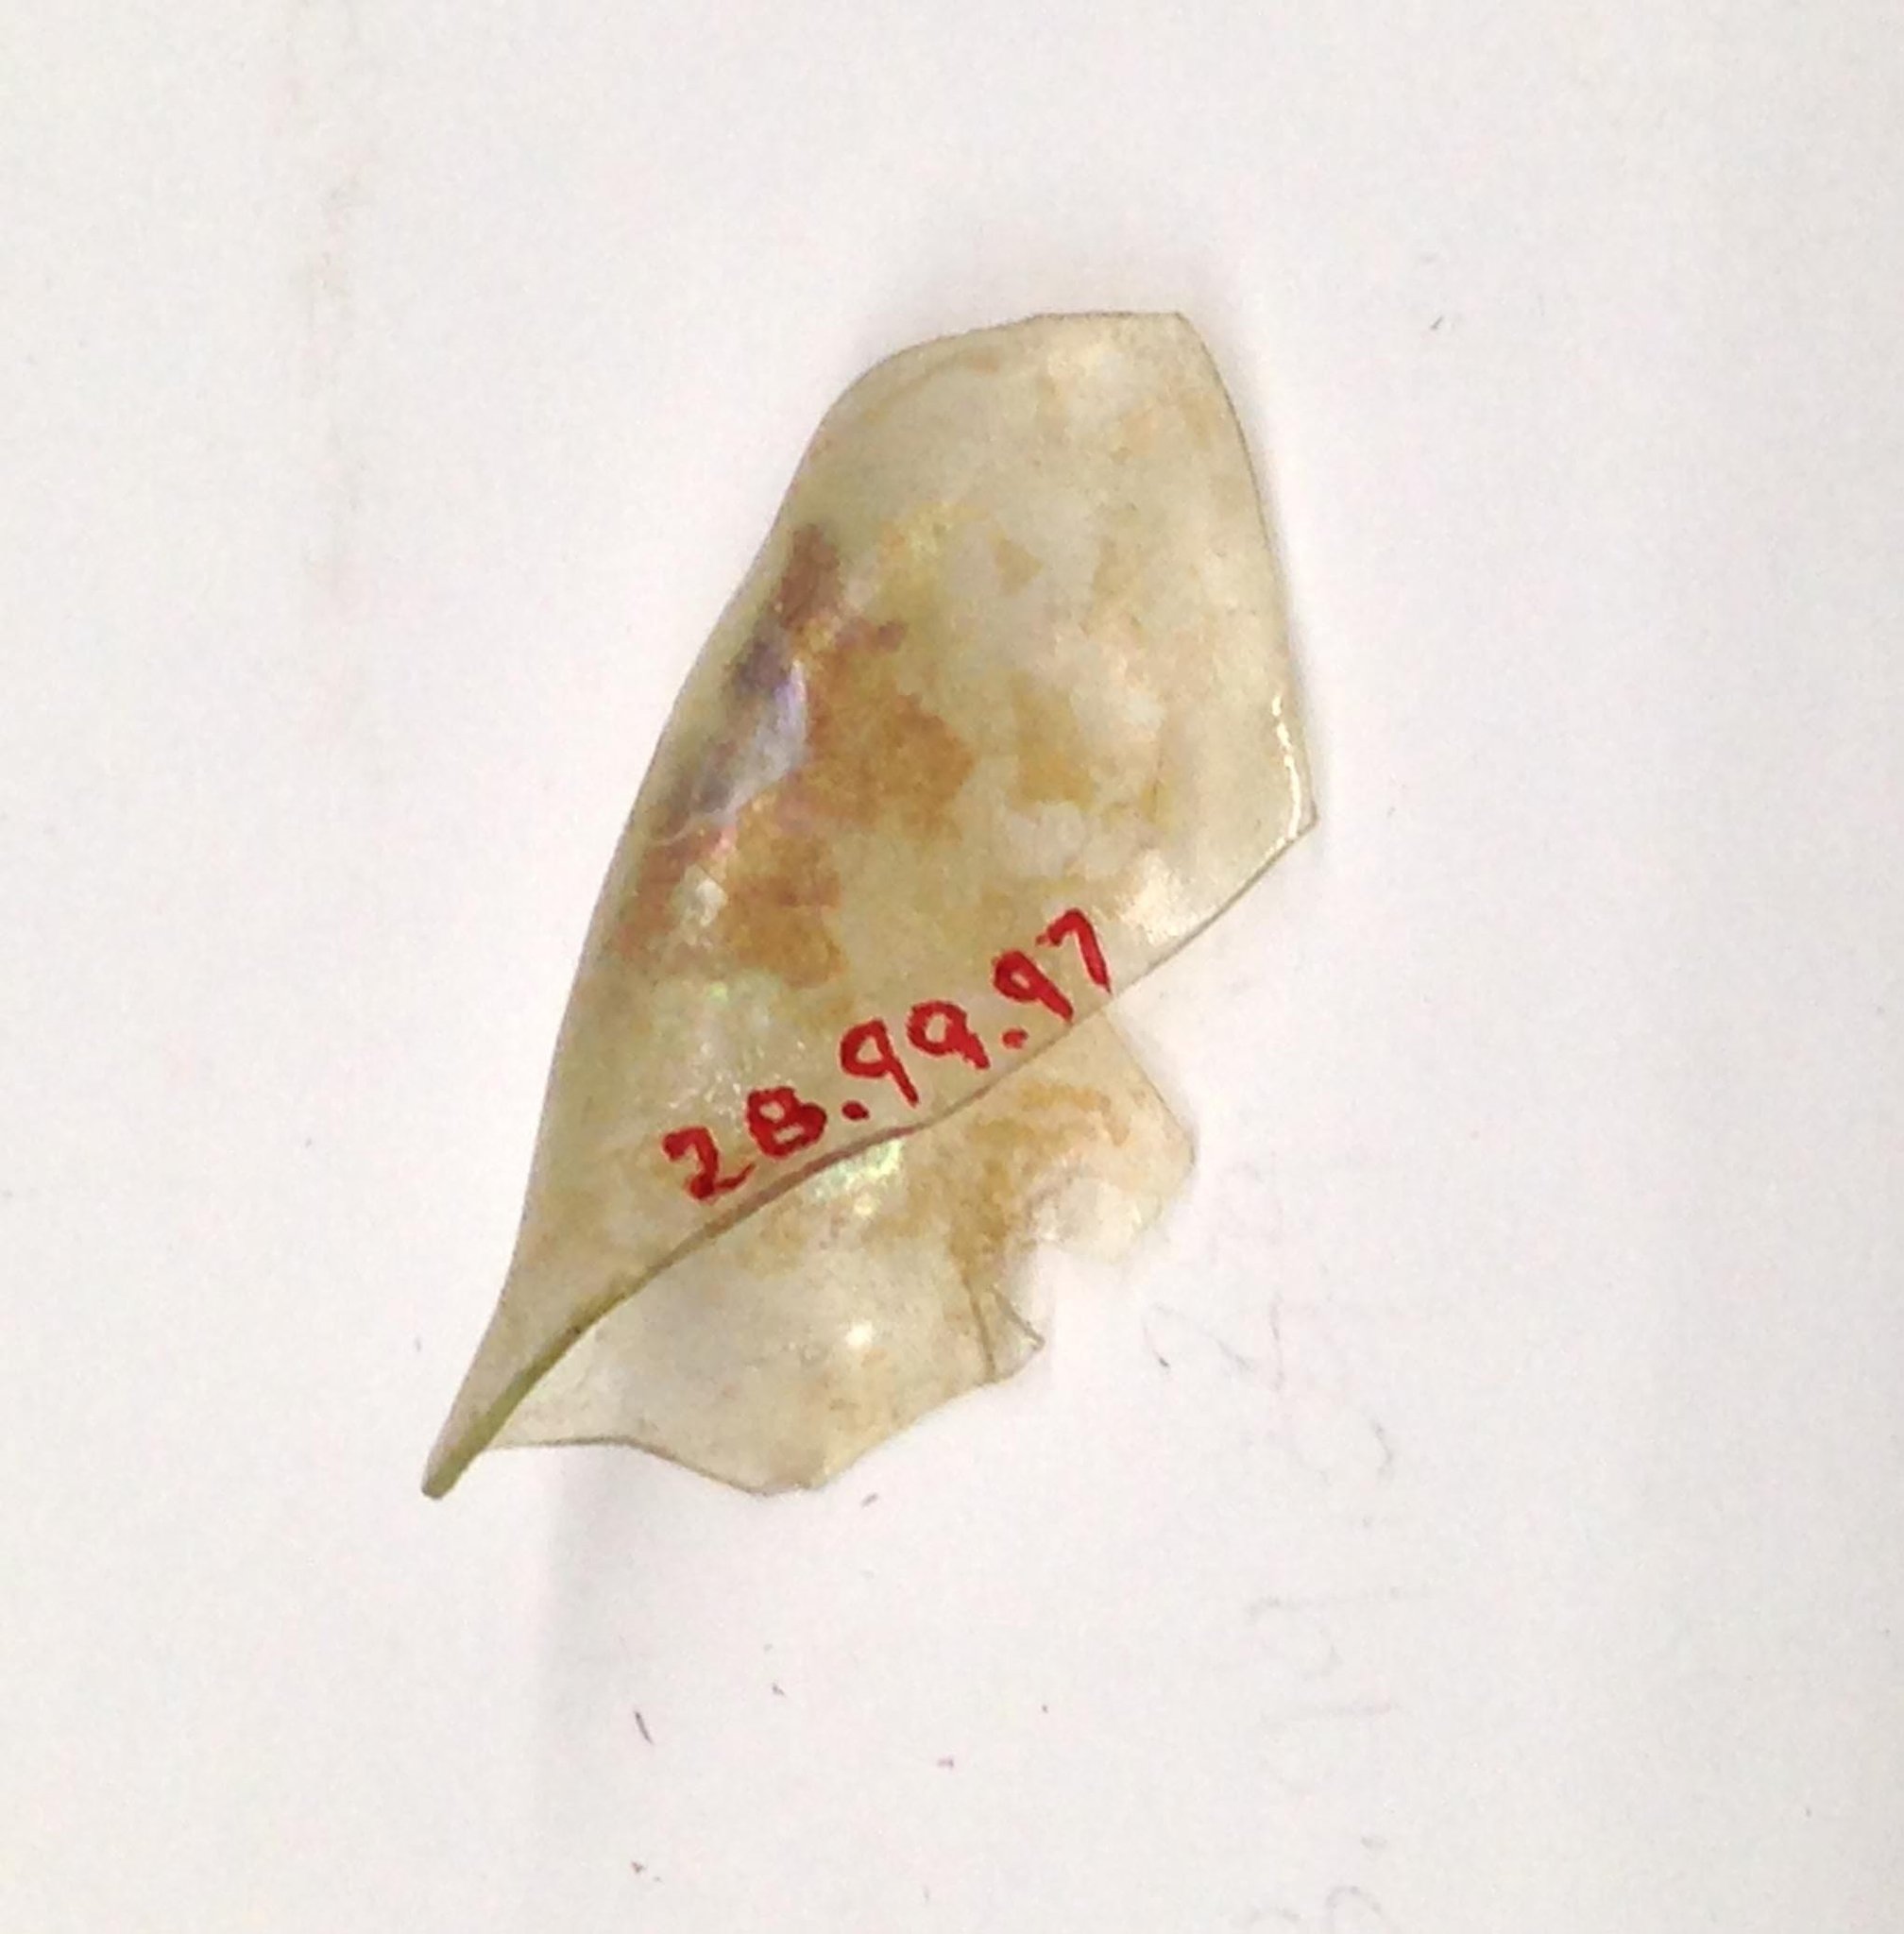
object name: fragment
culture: european or middle eastern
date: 1150-1250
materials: ceramic, glass